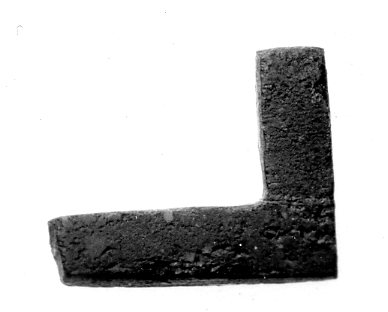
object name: amulet, surveyor's level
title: Surveyor's level Amulet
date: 664-332 BCE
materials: mineral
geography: egypt